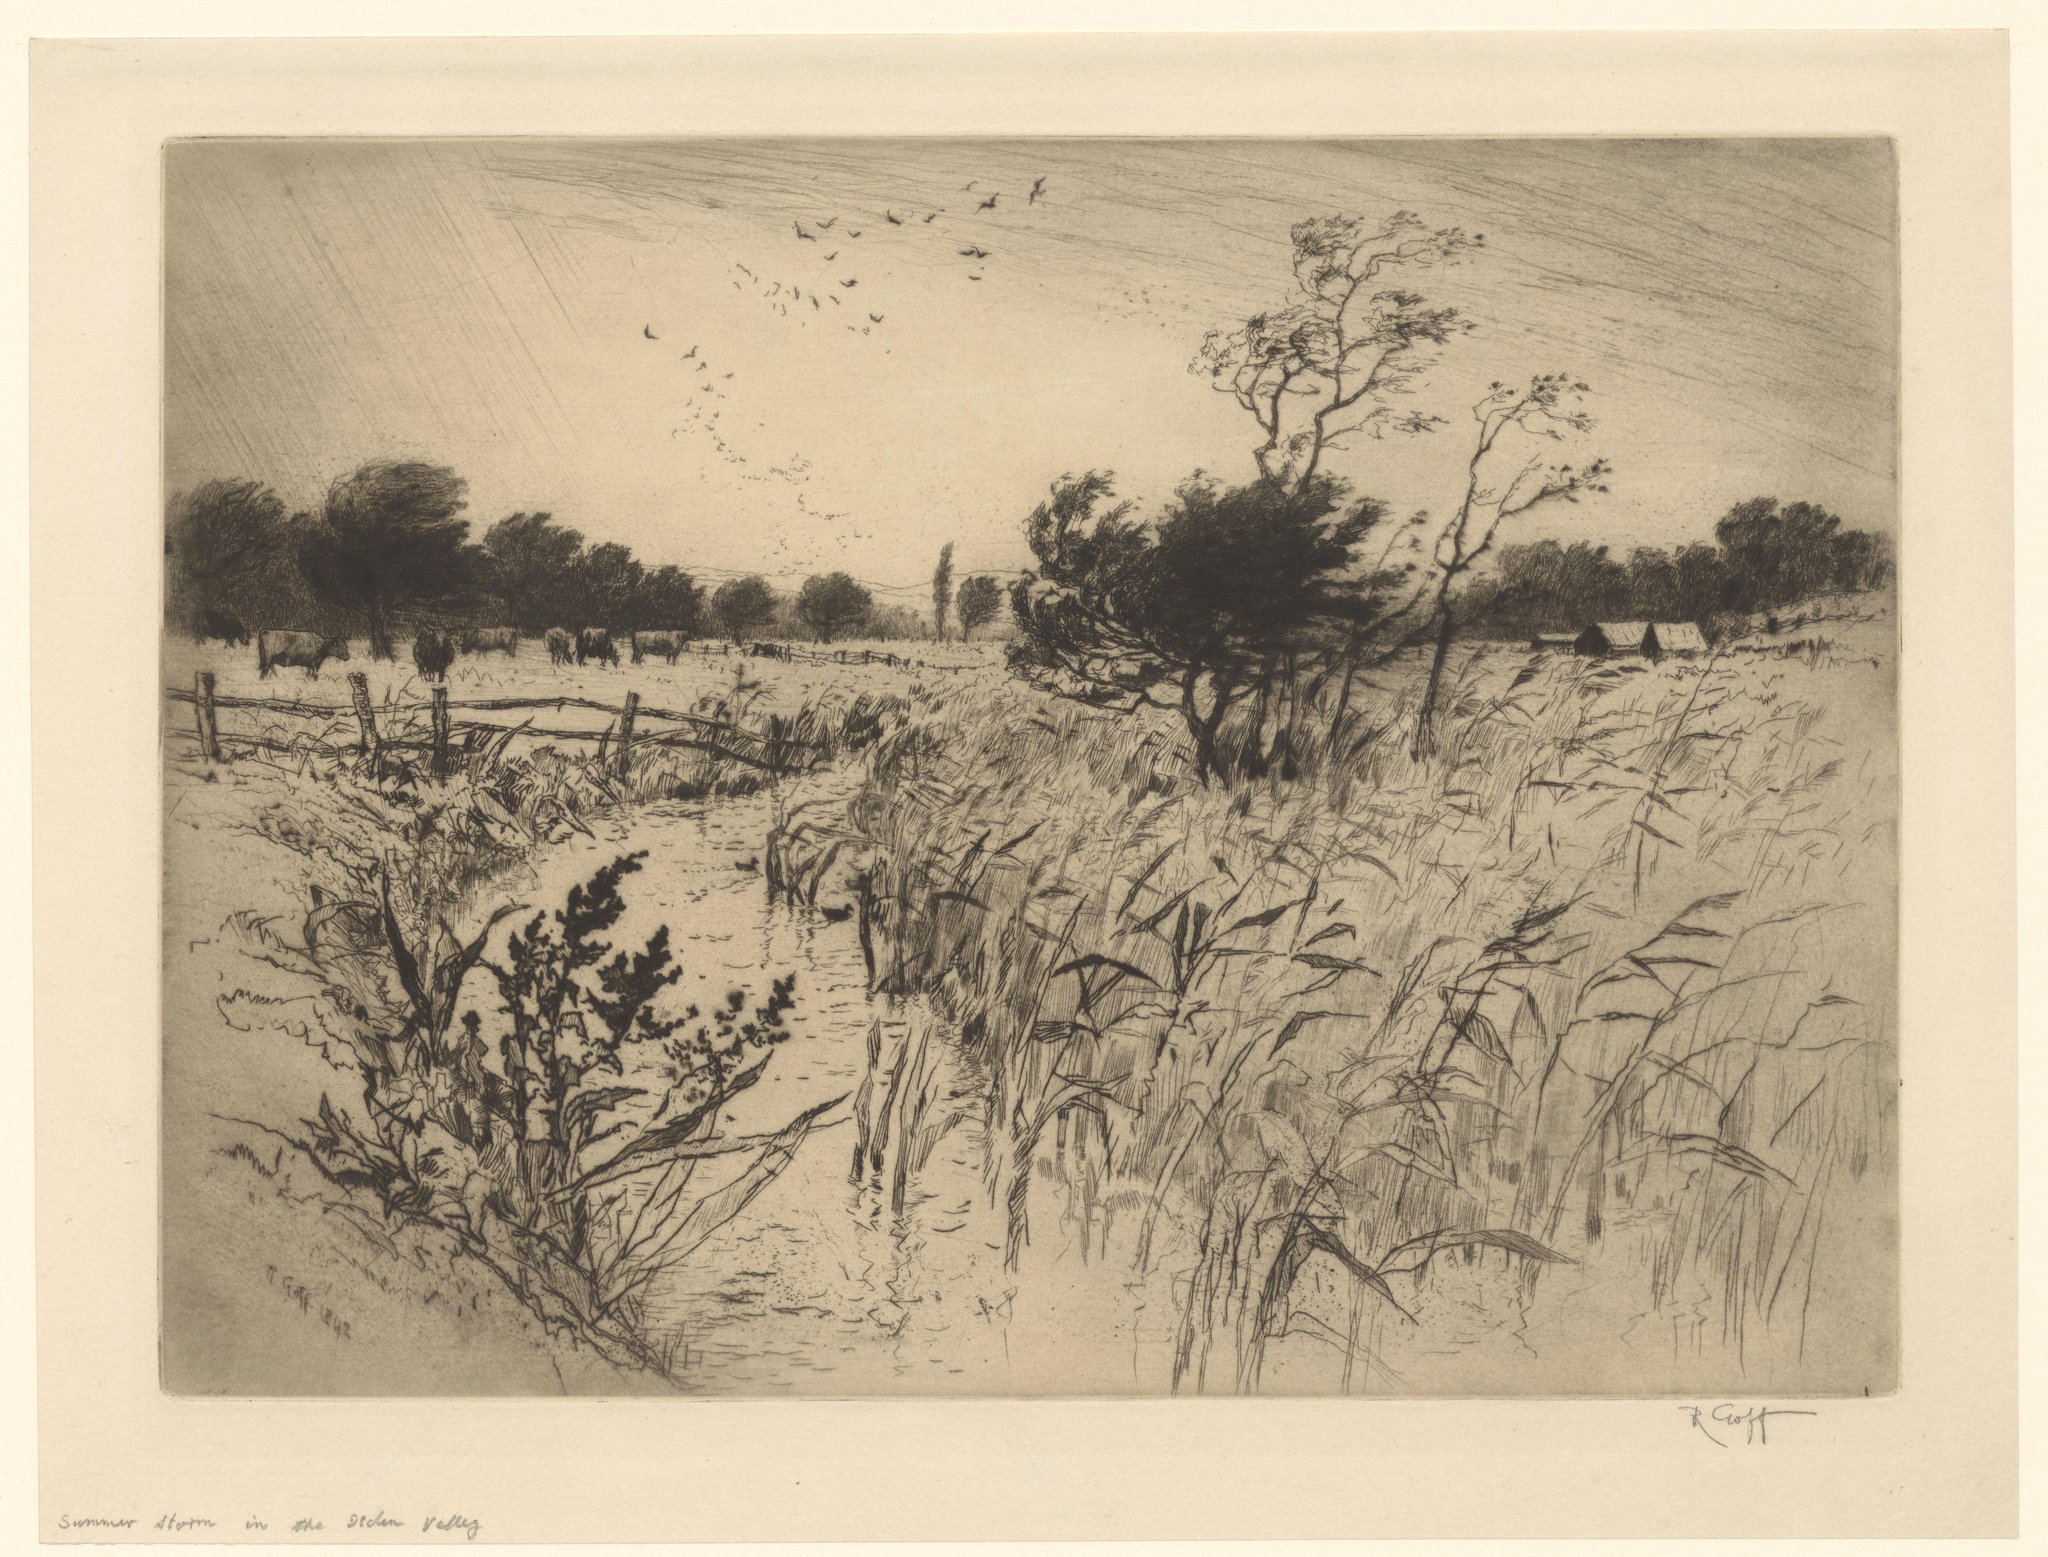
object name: print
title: Gezicht op een weide met koeien, een sloot en vogels in de lucht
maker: robert goff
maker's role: print maker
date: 1842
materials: paper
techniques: drypoint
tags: storm, meadow, pasture (+ landscape with figures, staffage)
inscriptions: collector's mark: Lugt 2228, collector's mark: Lugt 2760, annotation: ‘Summer storm in the Itchen Valley’